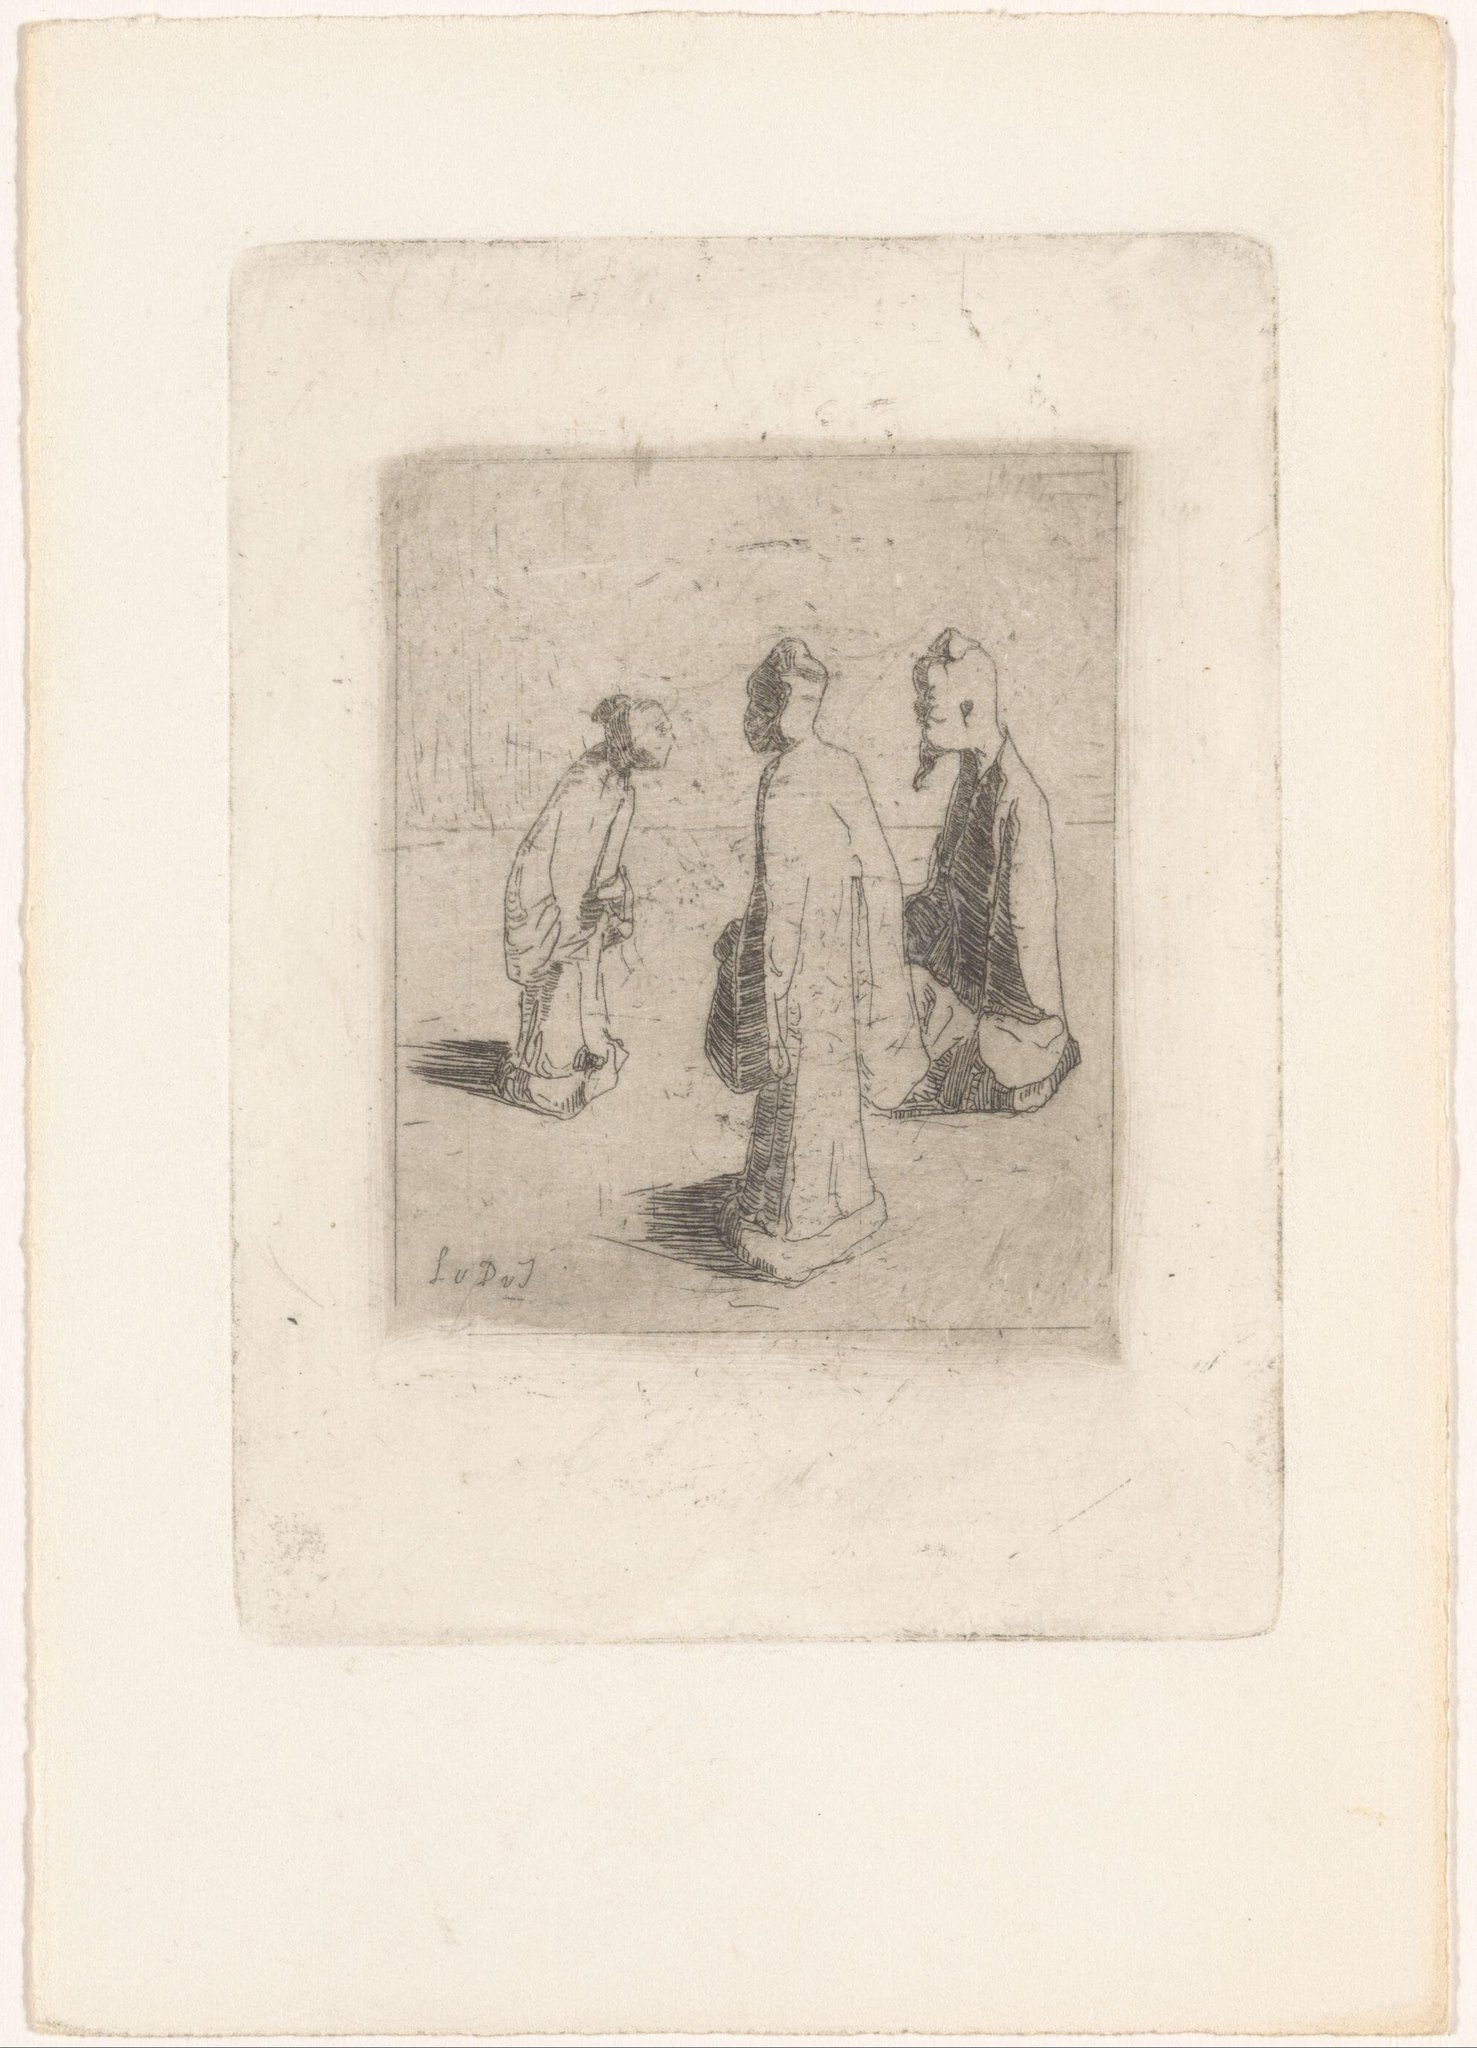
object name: print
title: Drie Aziatische beelden van menselijke figuren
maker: lucie van dam van isselt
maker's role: draughtsman, print maker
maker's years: 1871-1949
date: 1881-1949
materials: paper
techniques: etching, intaglio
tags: sculpture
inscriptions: collector's mark: Lugt 2228